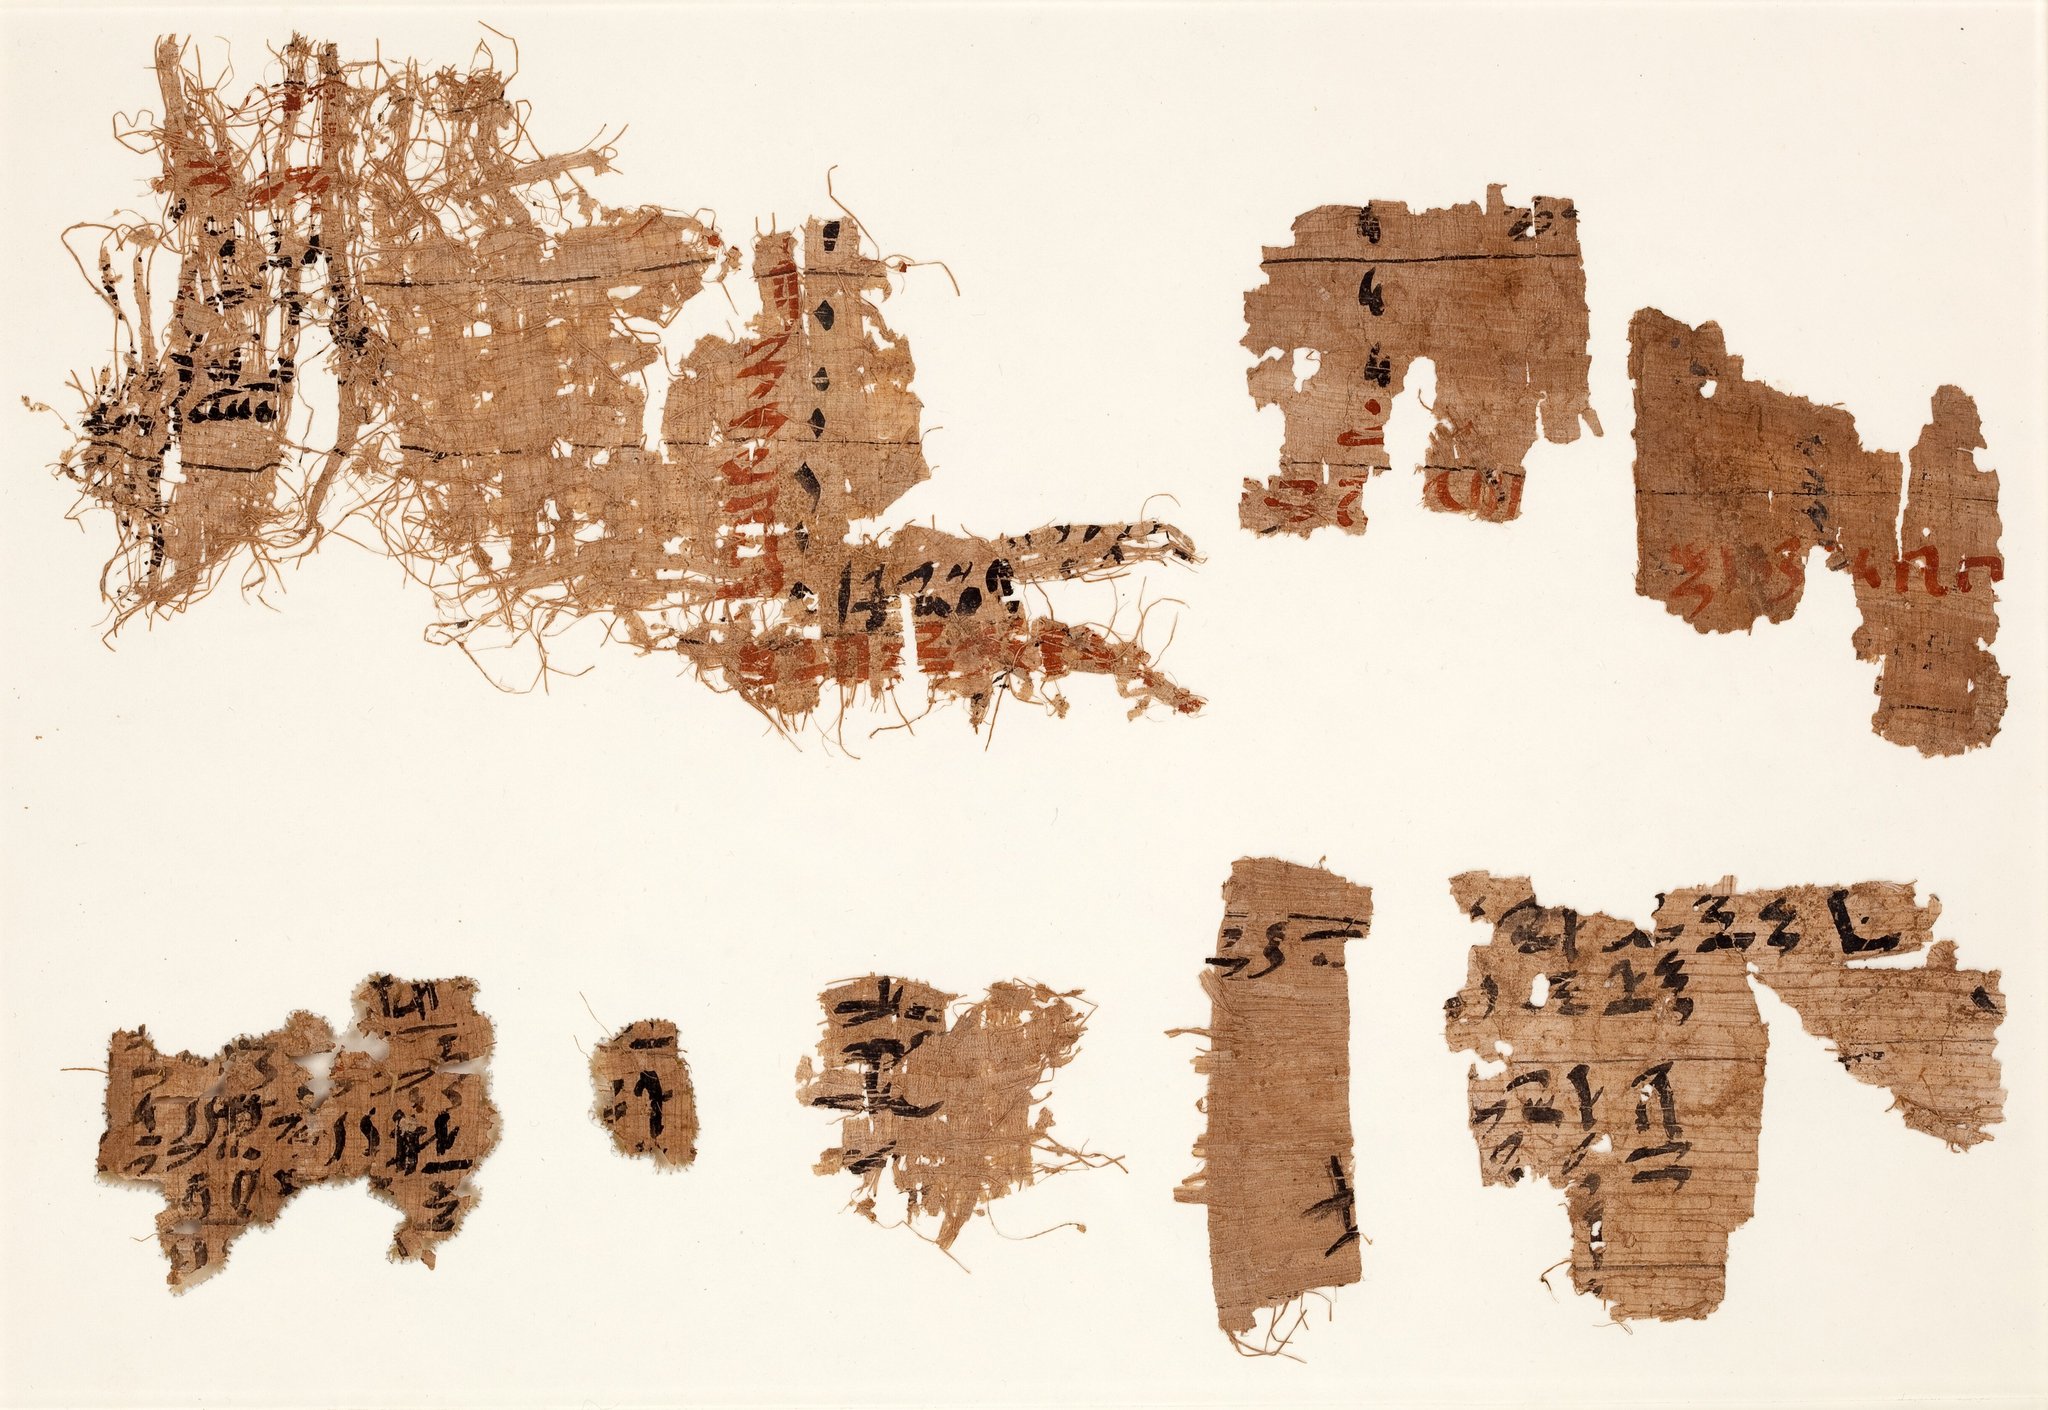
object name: papyrus, letter, hieratic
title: Nine fragments of hieratic text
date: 1981-1640 BCE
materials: ink, papyrus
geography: egypt